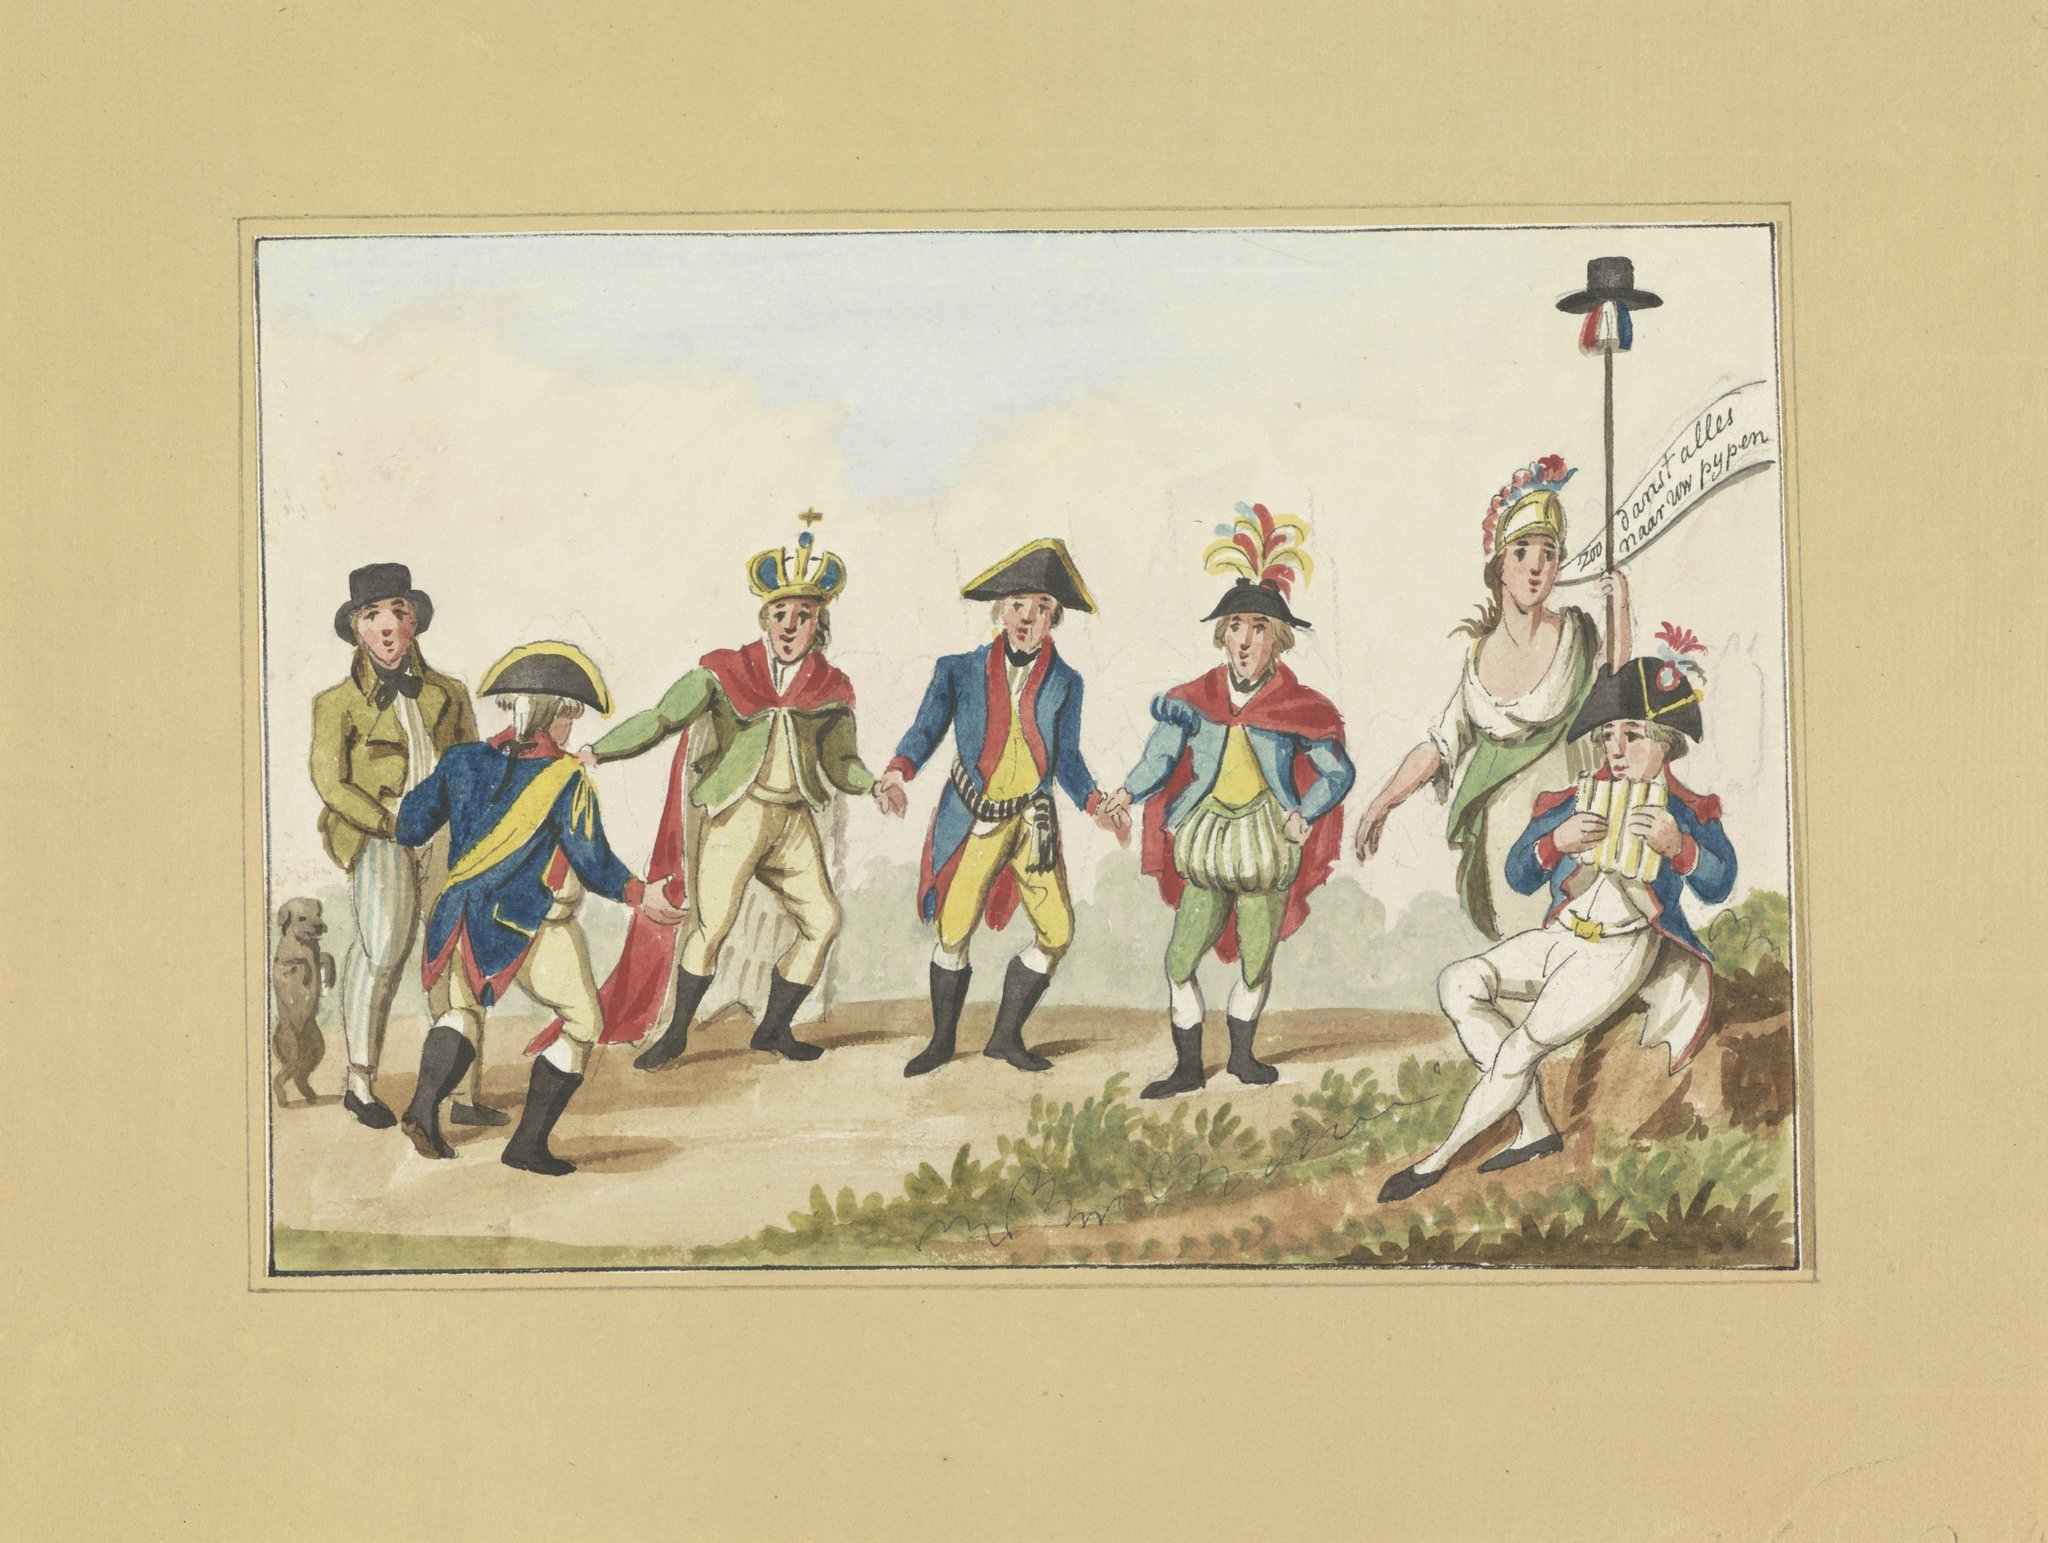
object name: drawing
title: Alle landen dansen naar het pijpen van Frankrijk, 1795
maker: Anonymous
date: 1795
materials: paper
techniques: brush, pen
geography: netherlands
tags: transverse flute - cc - out of doors, personifications of countries, nations, states, districts, etc., group of men (folk dancing), netherlands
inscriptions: collector's mark: Lugt 2228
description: Een Franse soldaat blaast op een panfluit terwijl voor hem vertegenwoordigers van Europese landen dansen. Rechts naast Frankrijk staat de Nederlandse Maagd.